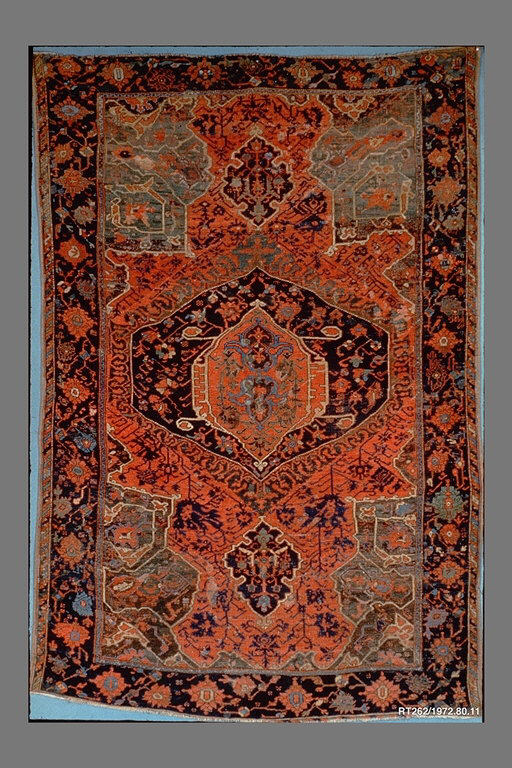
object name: carpet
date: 1701-1800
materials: wool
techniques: pile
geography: turkey